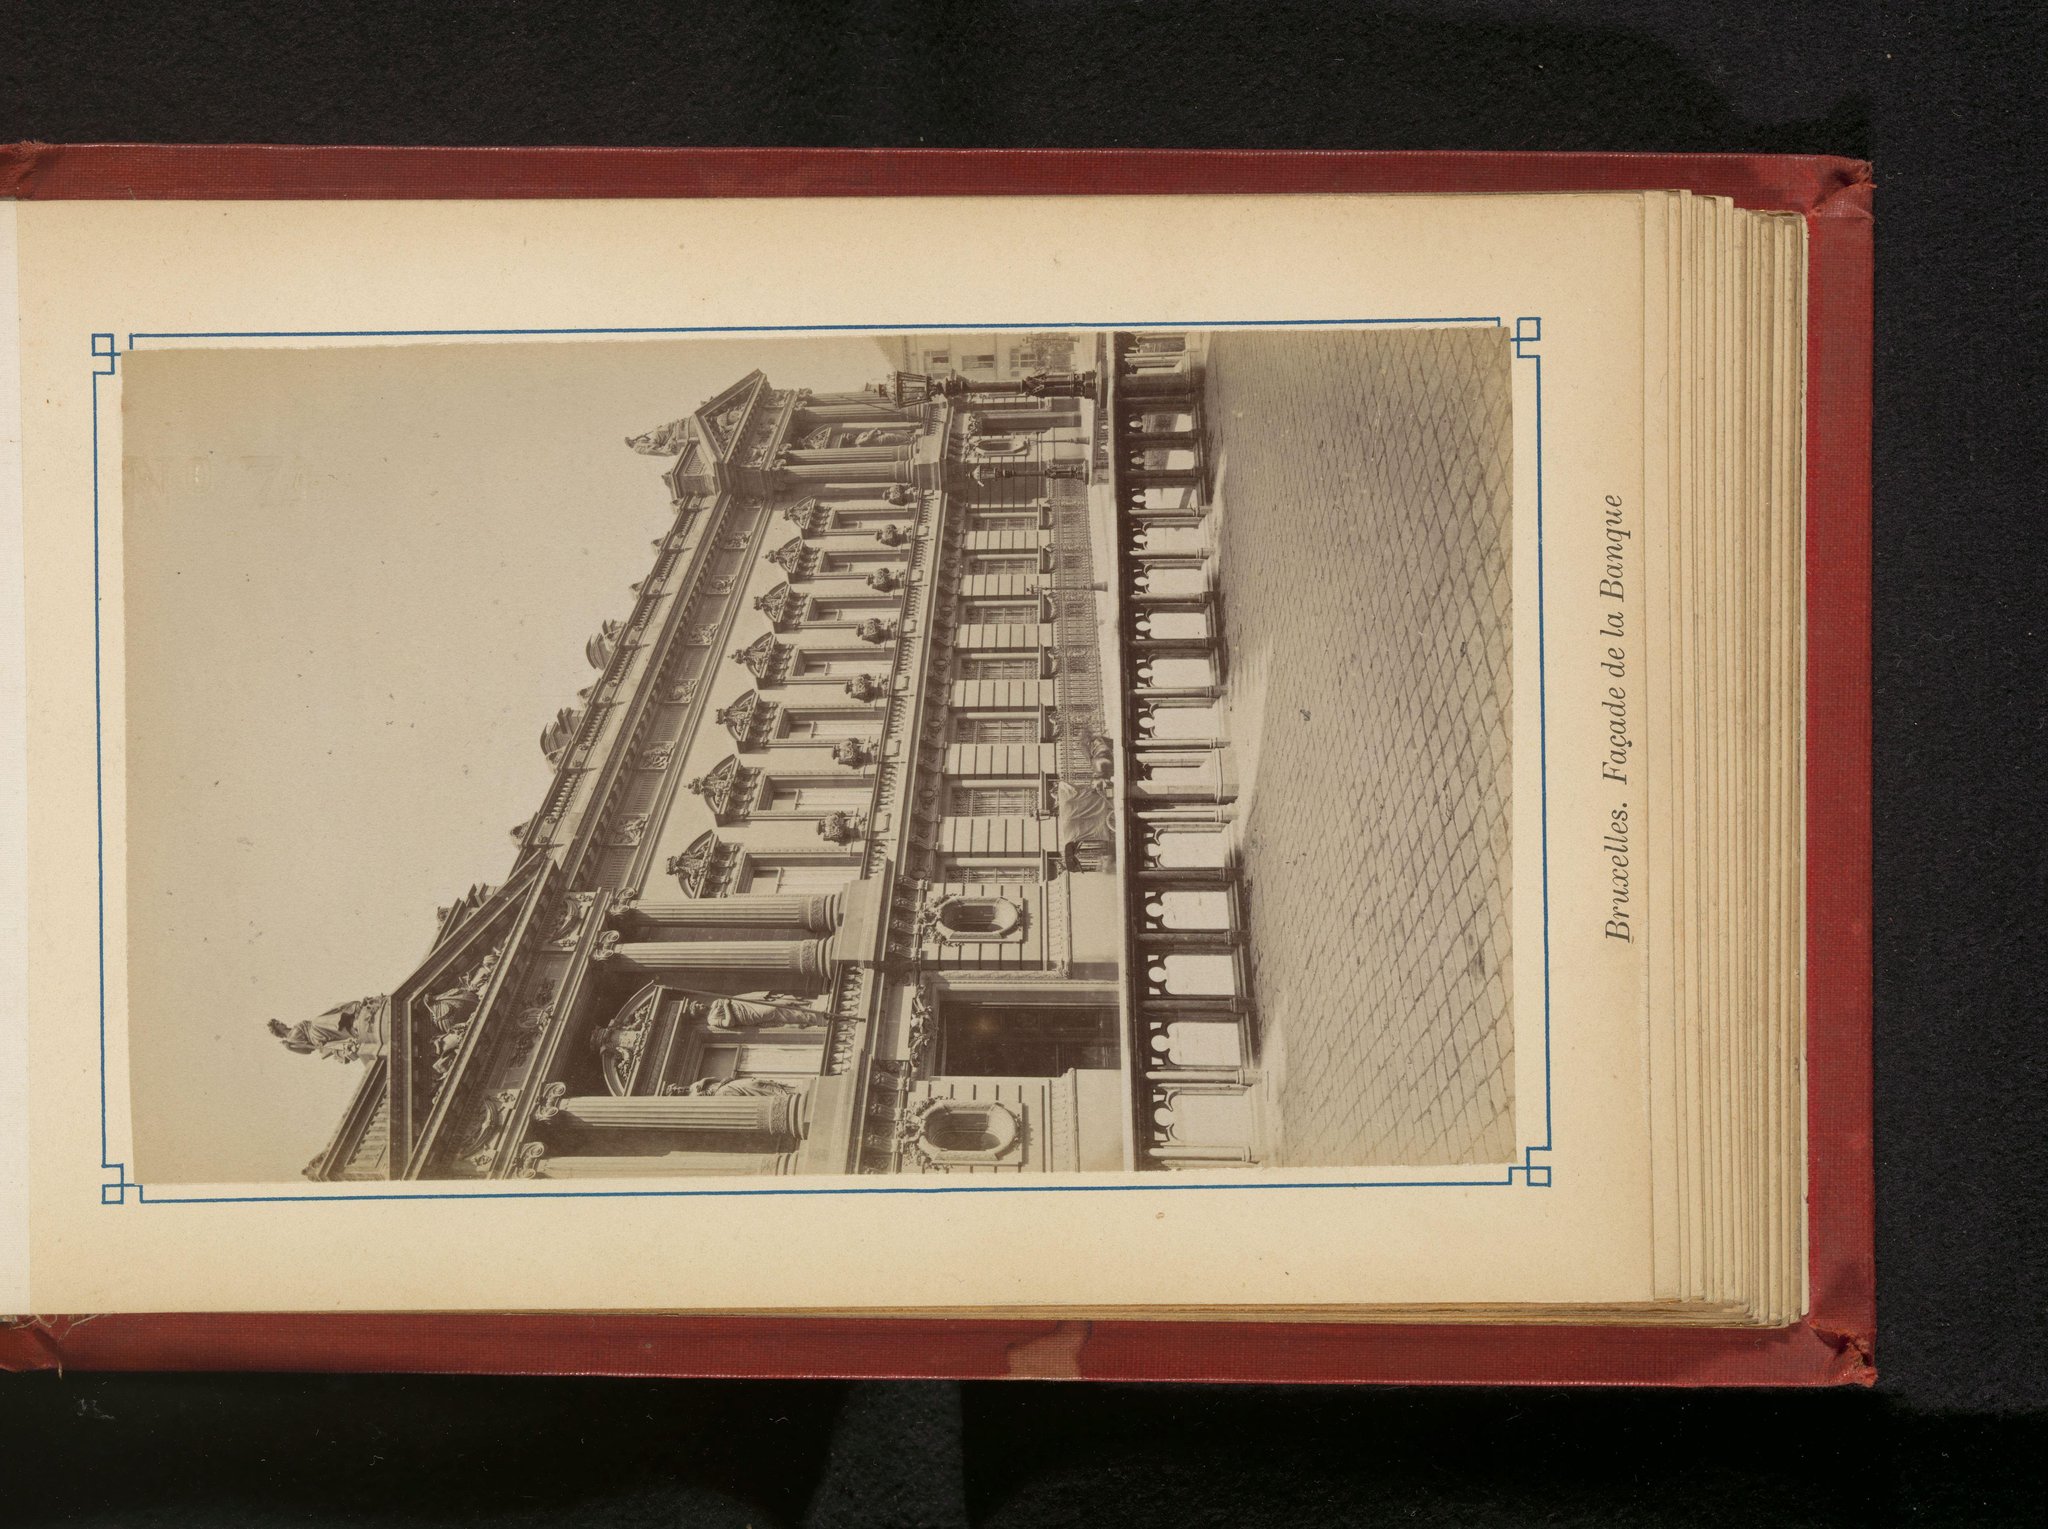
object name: photograph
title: Bruxelles. Façade de la Banque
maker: Anonymous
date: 1875-1880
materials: photographic support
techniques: albumen print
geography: brussels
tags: façade (of house or building), bank, brussels